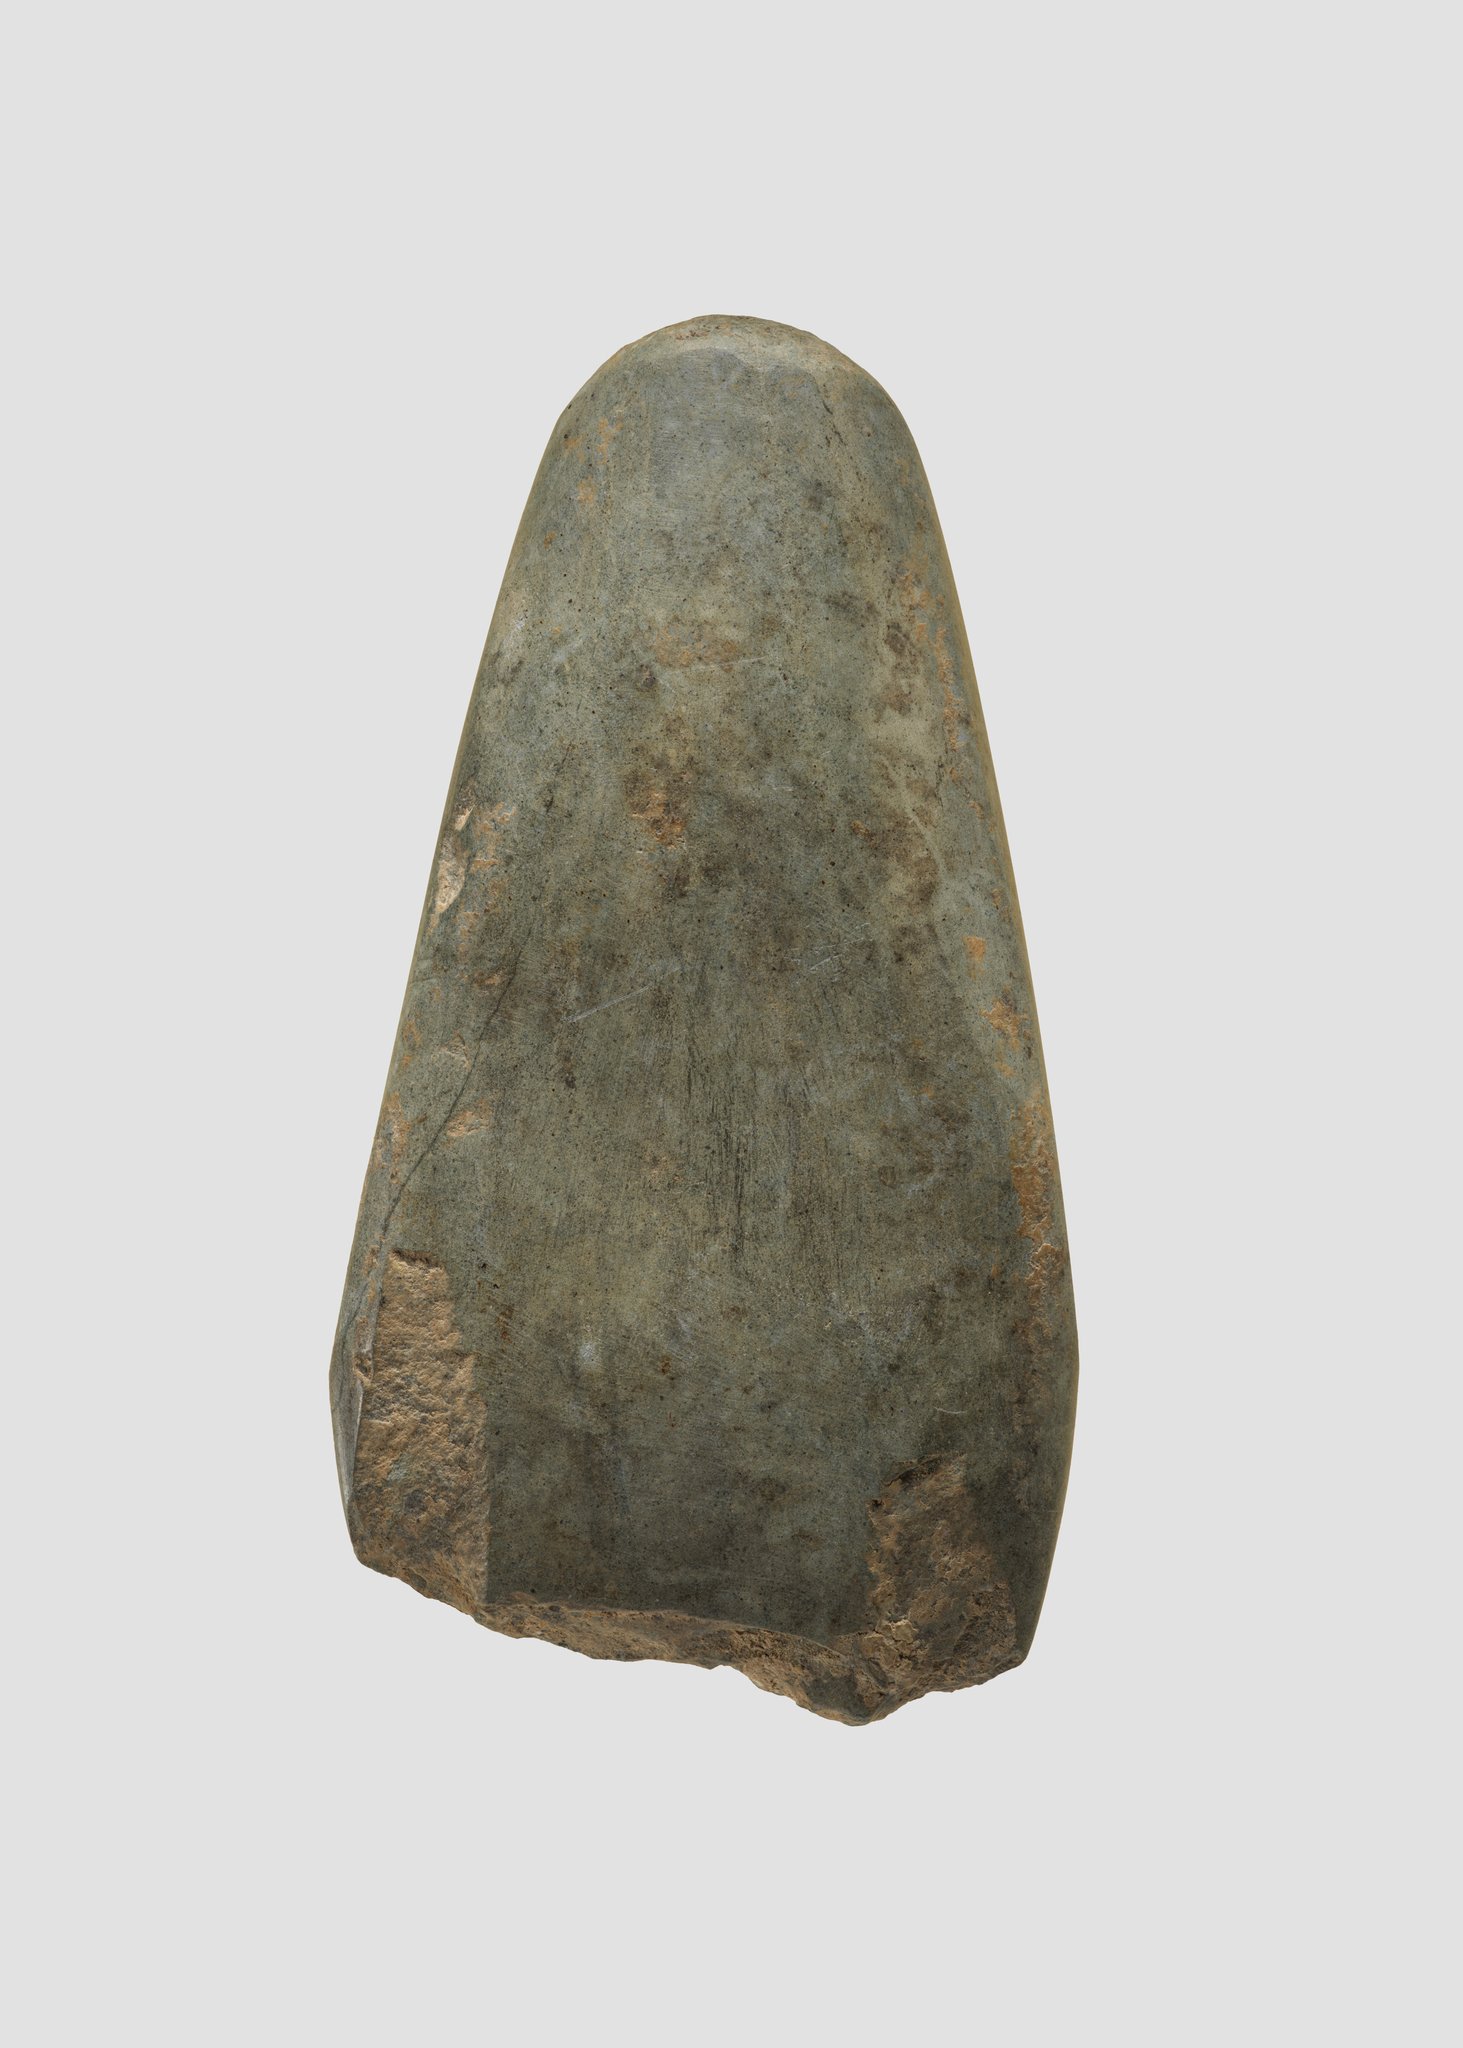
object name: celt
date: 7333-7001 BCE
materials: stone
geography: syria